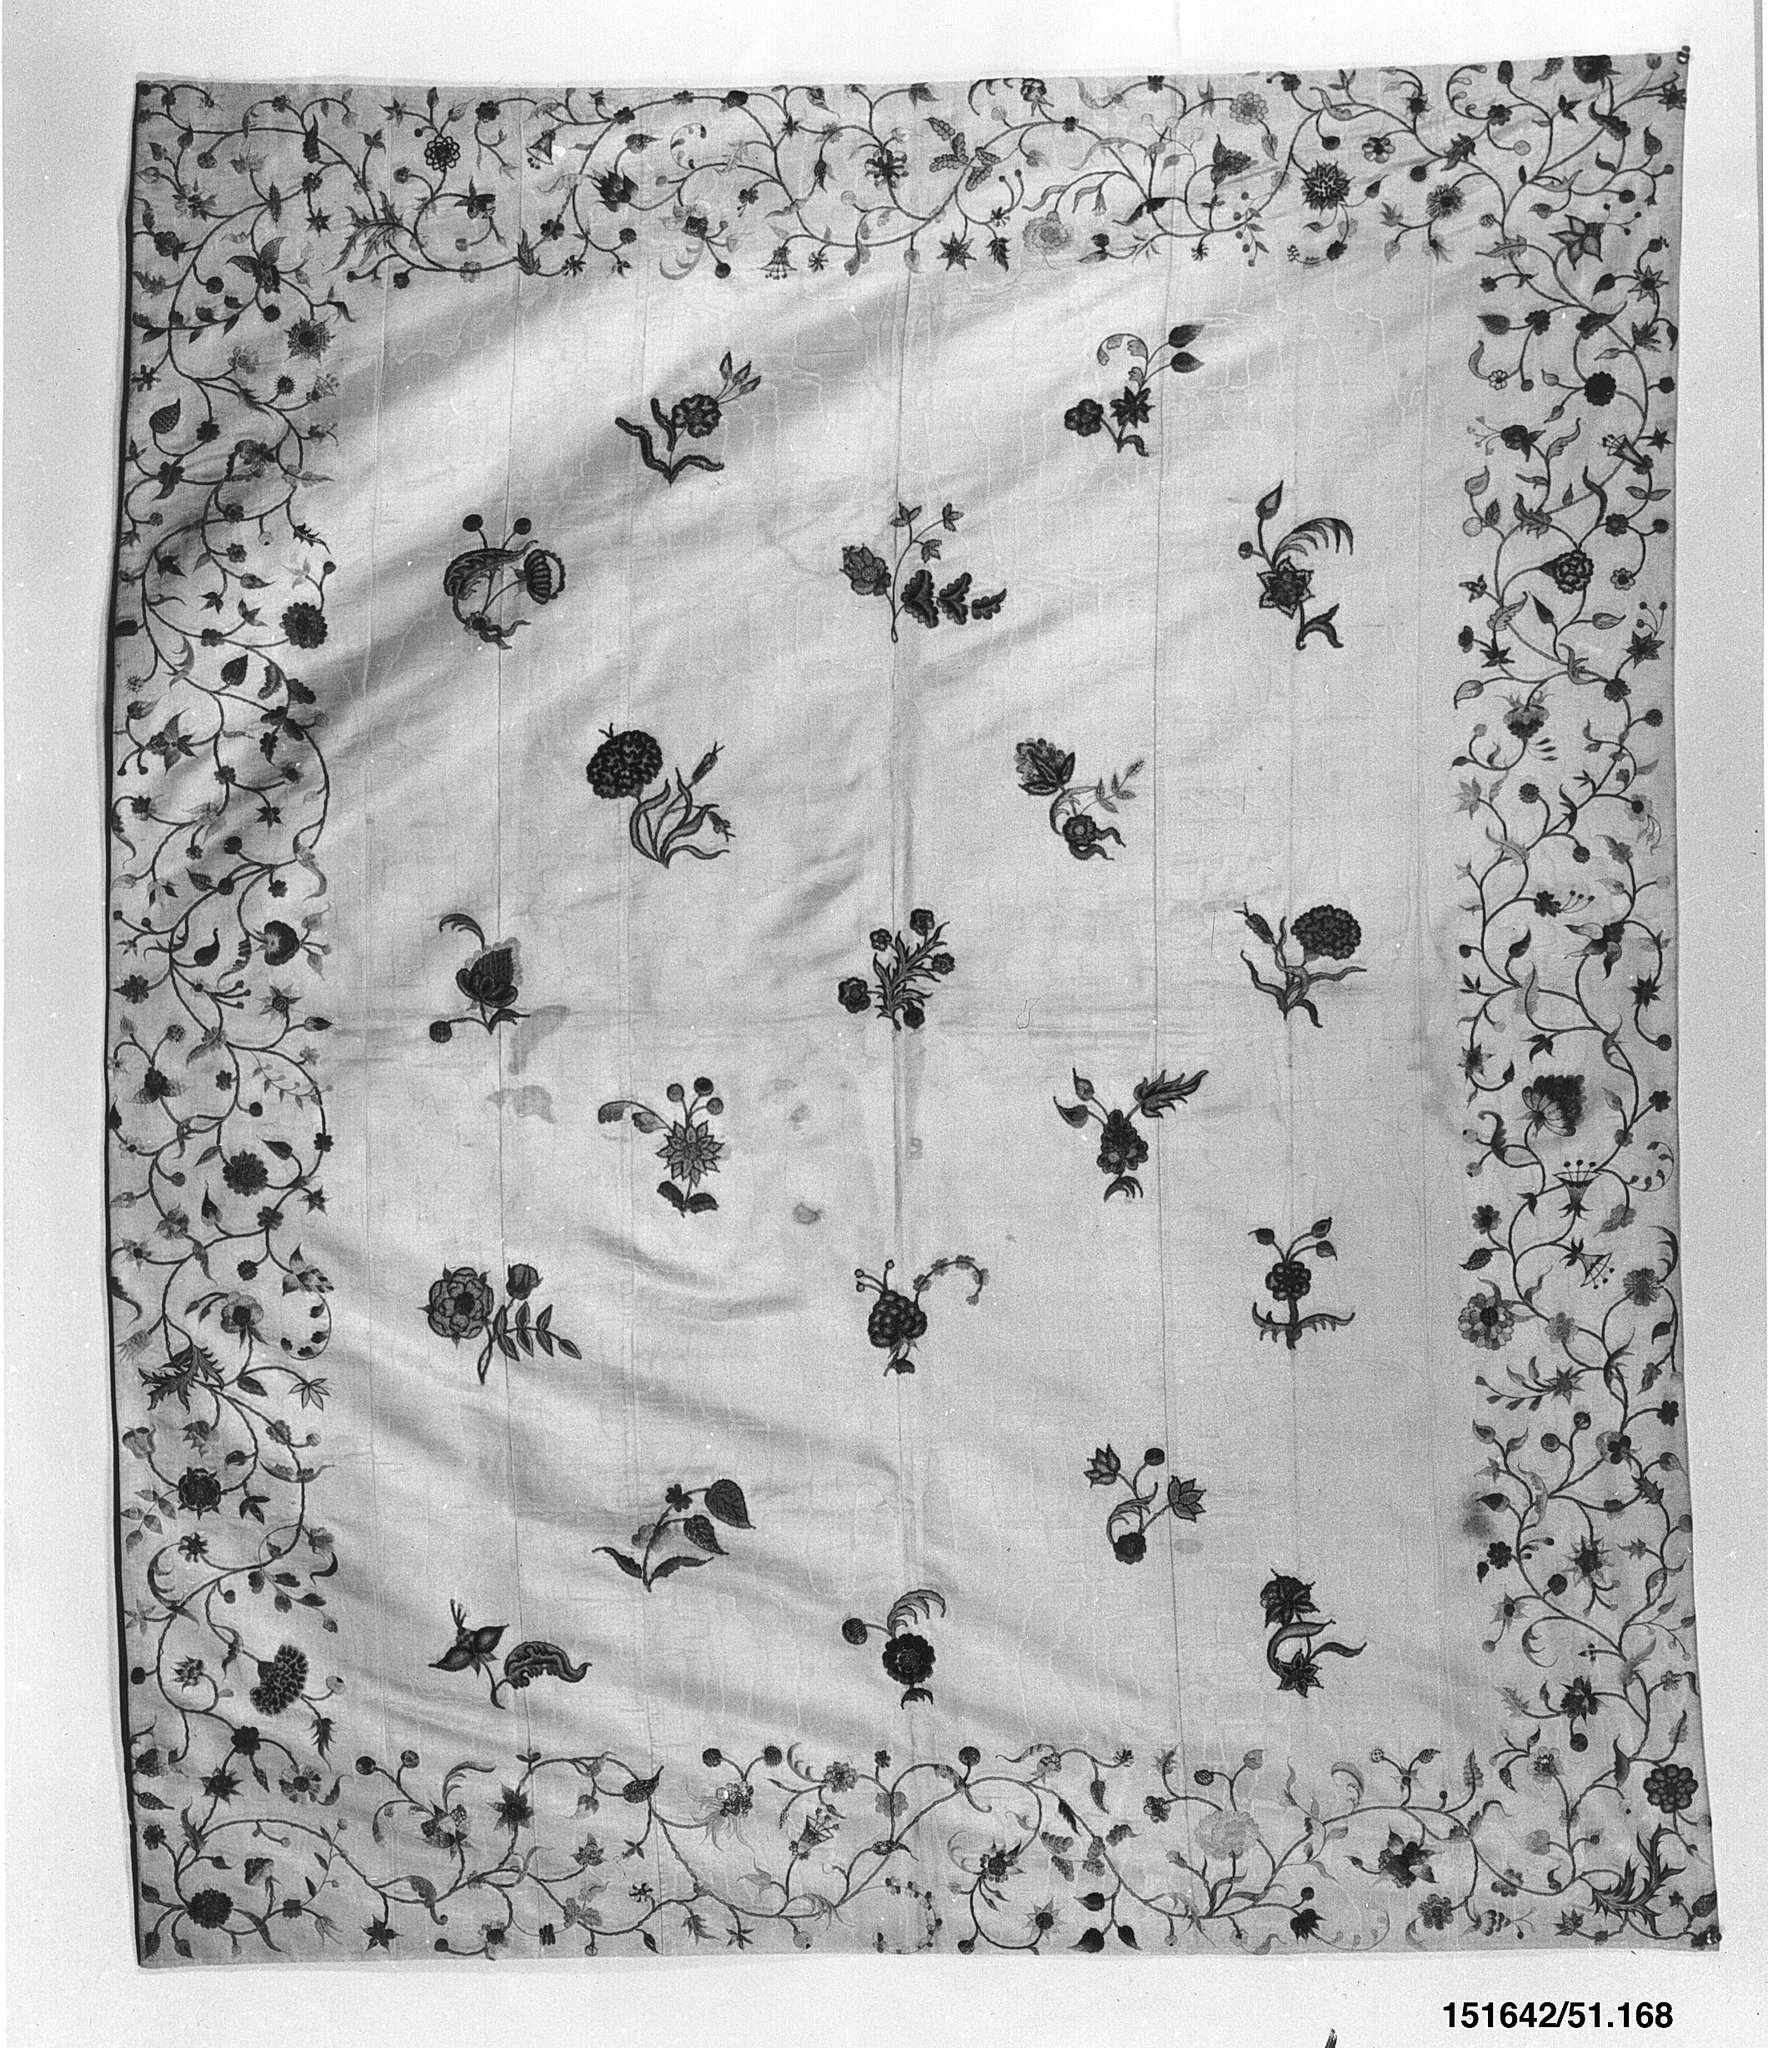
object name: cover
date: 1701-1750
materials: metal thread, silk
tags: flowers